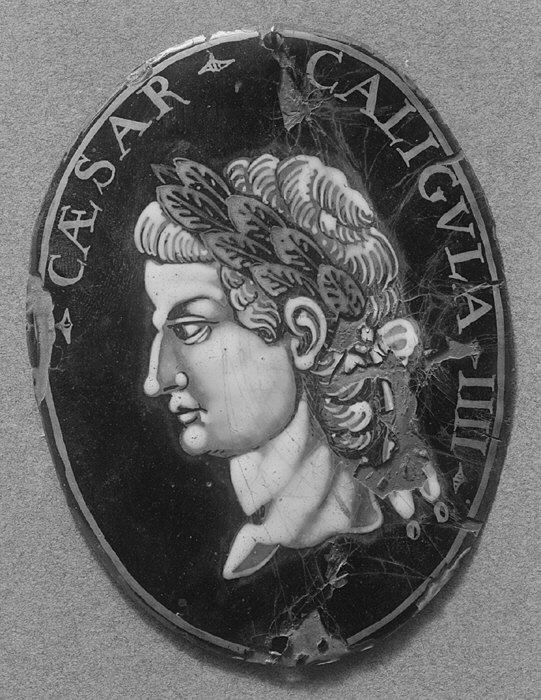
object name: plaque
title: Emperor Caligula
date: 1667-1733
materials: copper, enamel, gilt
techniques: painting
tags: men,profiles,leaves